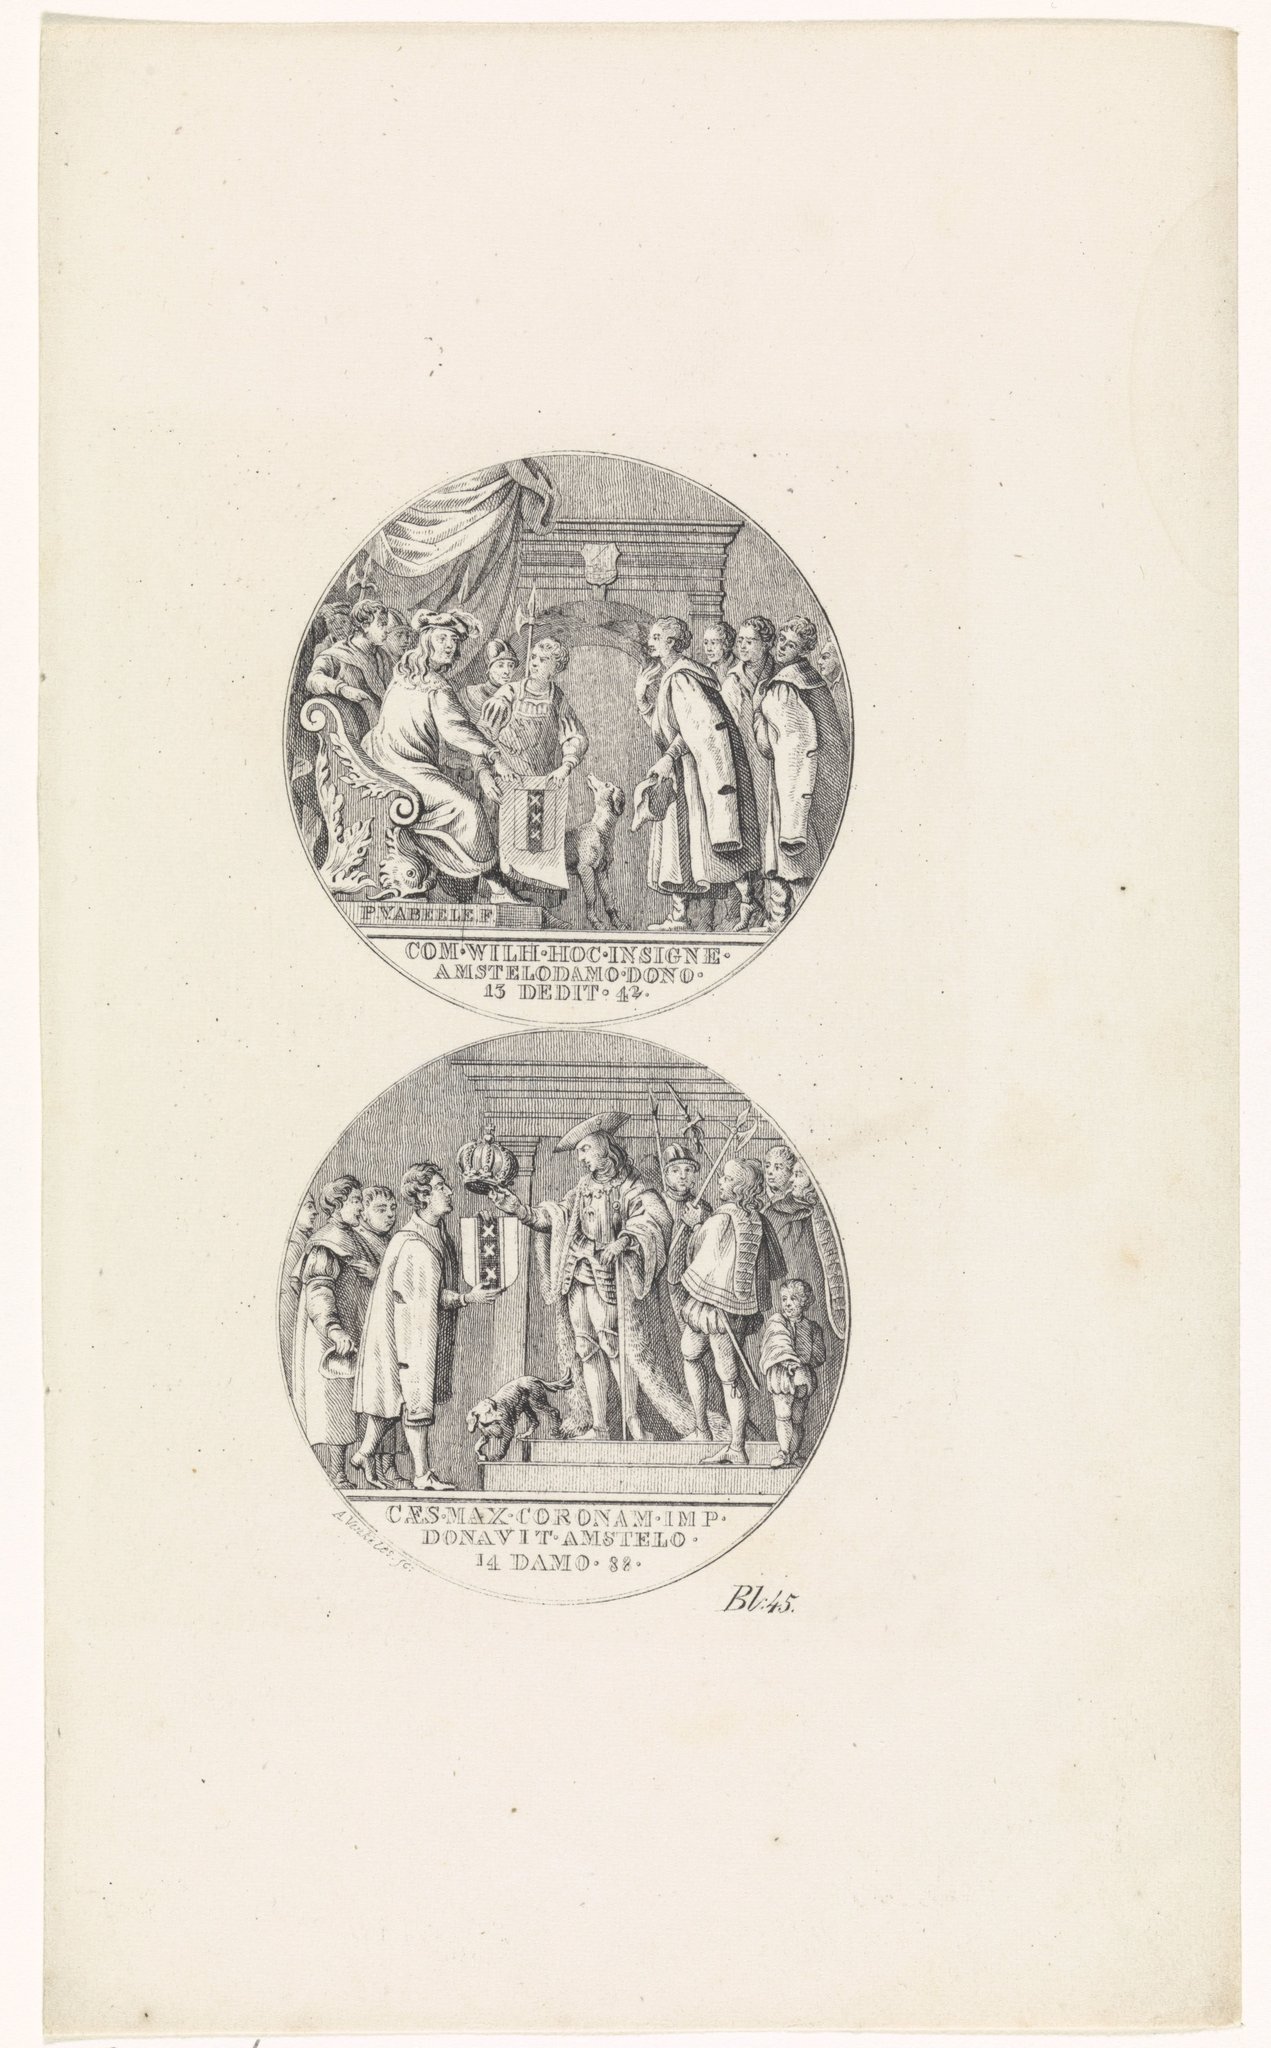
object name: print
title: Twee medailles met historische voorstellingen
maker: abraham vinkeles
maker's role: draughtsman, print maker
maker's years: 1790-1864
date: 1800-1864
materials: paper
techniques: engraving, etching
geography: amsterdam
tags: maximilian i (holy roman emperor), willem iv (graaf van holland), memorial medal, amsterdam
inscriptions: collector's mark: Lugt 2228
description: Twee medailles. Boven: Graaf Willem IV van Holland geeft Amsterdam een nieuw handvest waarin de status van de stad is vastgelegd, in 1342. Onder: Keizer Maximiliaan geeft het keizerlijke wapen aan het Amsterdamse stadswapen, in 1488. Rechtsonder: Bl. 45.